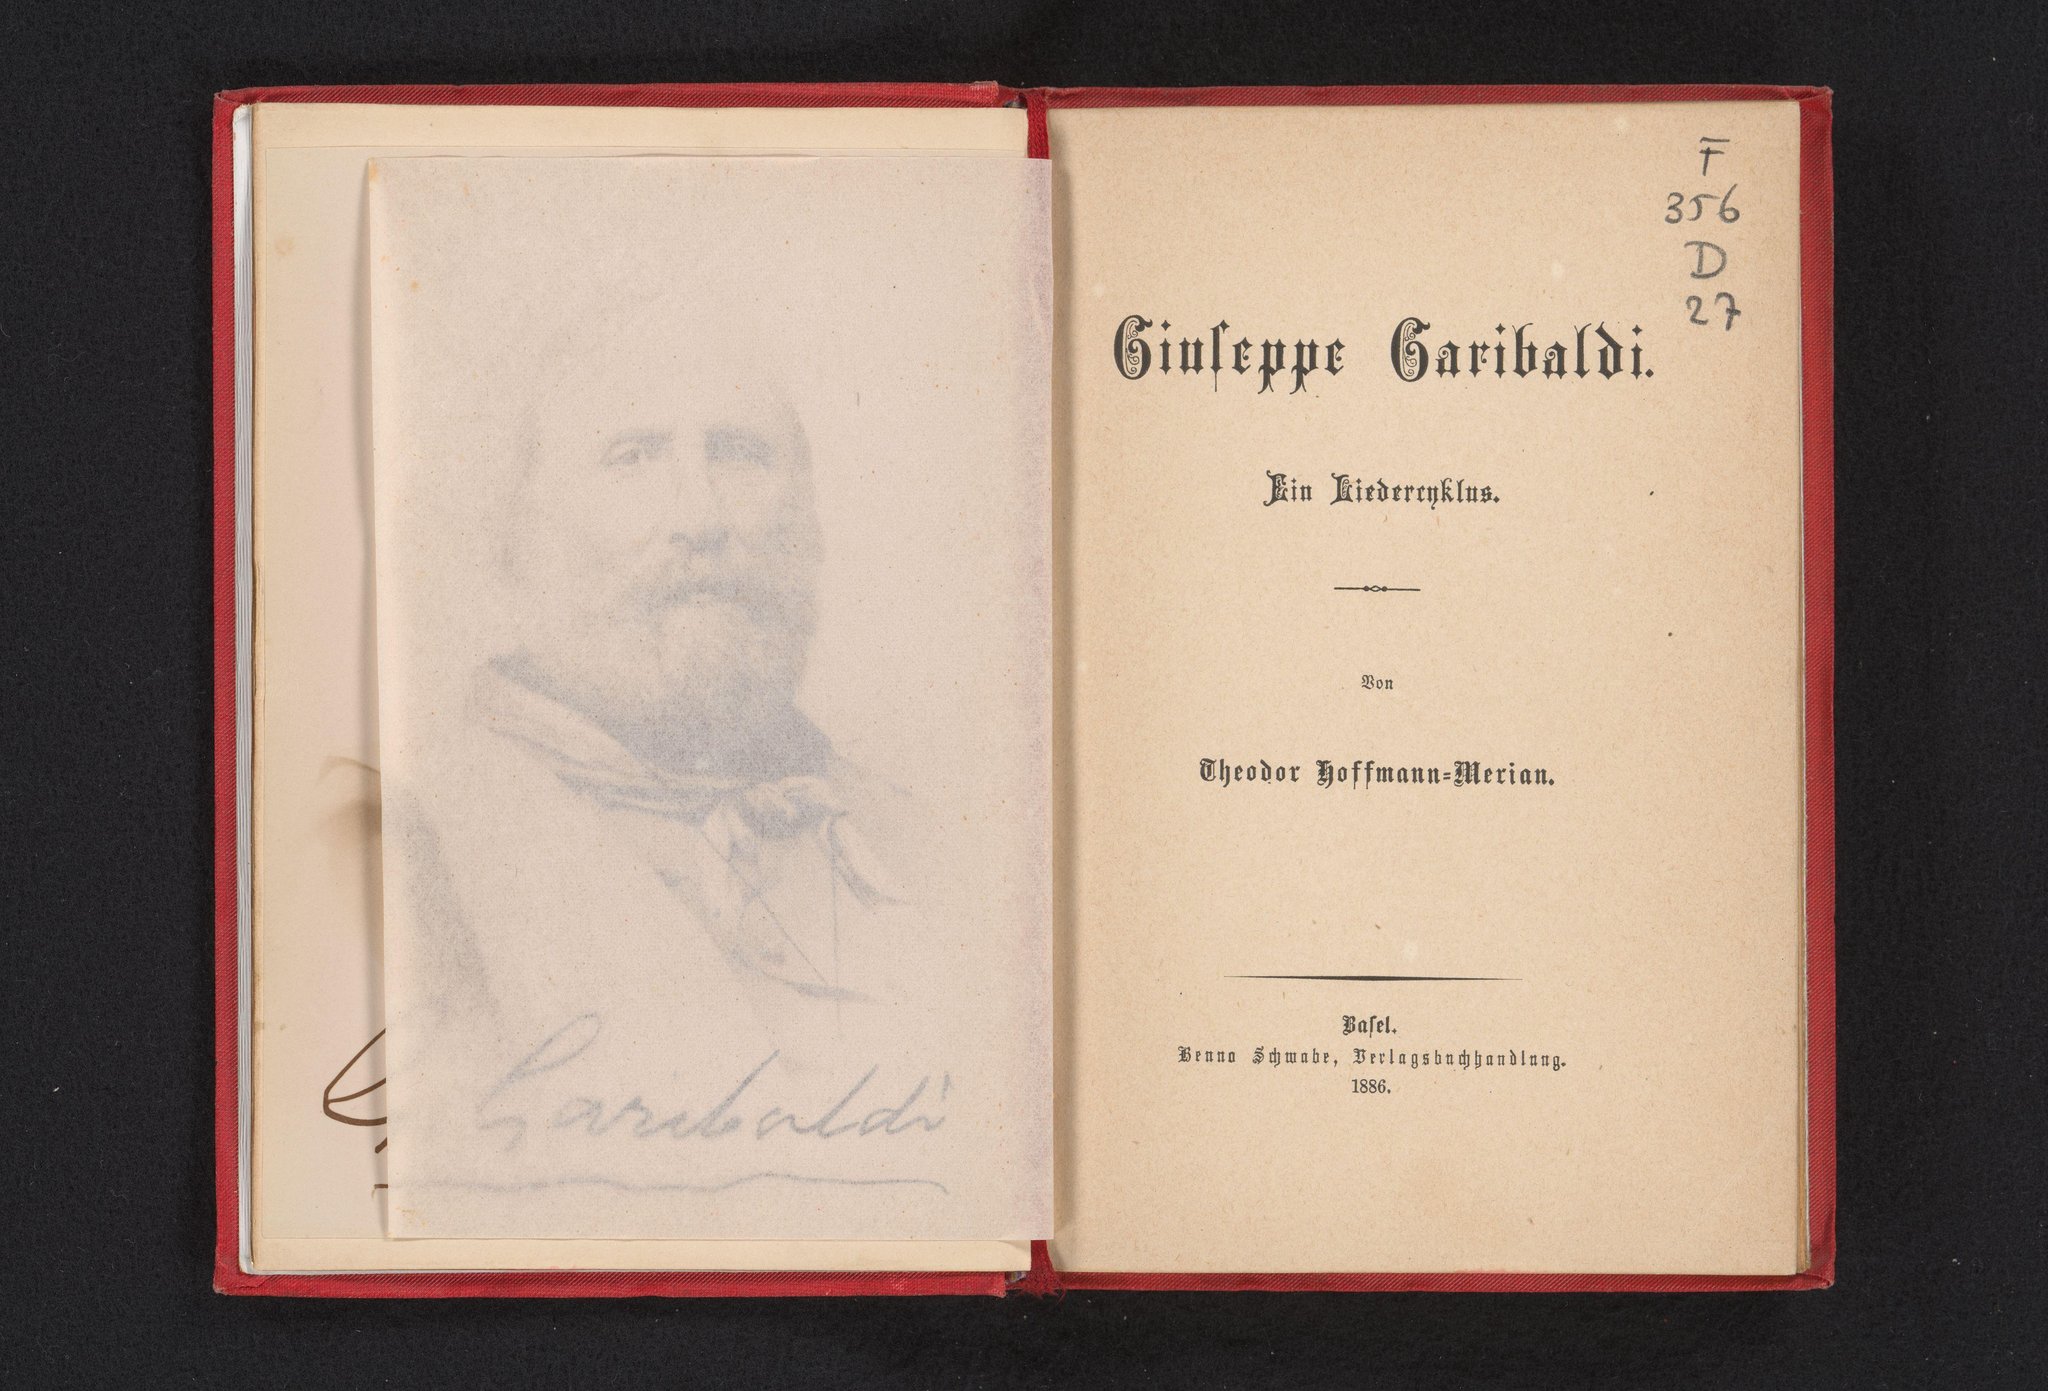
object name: book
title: Giuseppe Garibaldi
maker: benno schwabe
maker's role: publisher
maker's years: 1841-1907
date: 1886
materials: cardboard, linen, paper, photographic support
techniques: albumen print, printing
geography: basel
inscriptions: inscription: ‘[...] Johannna Sailer-Bierlich im Freundschaft vom Verfasser’